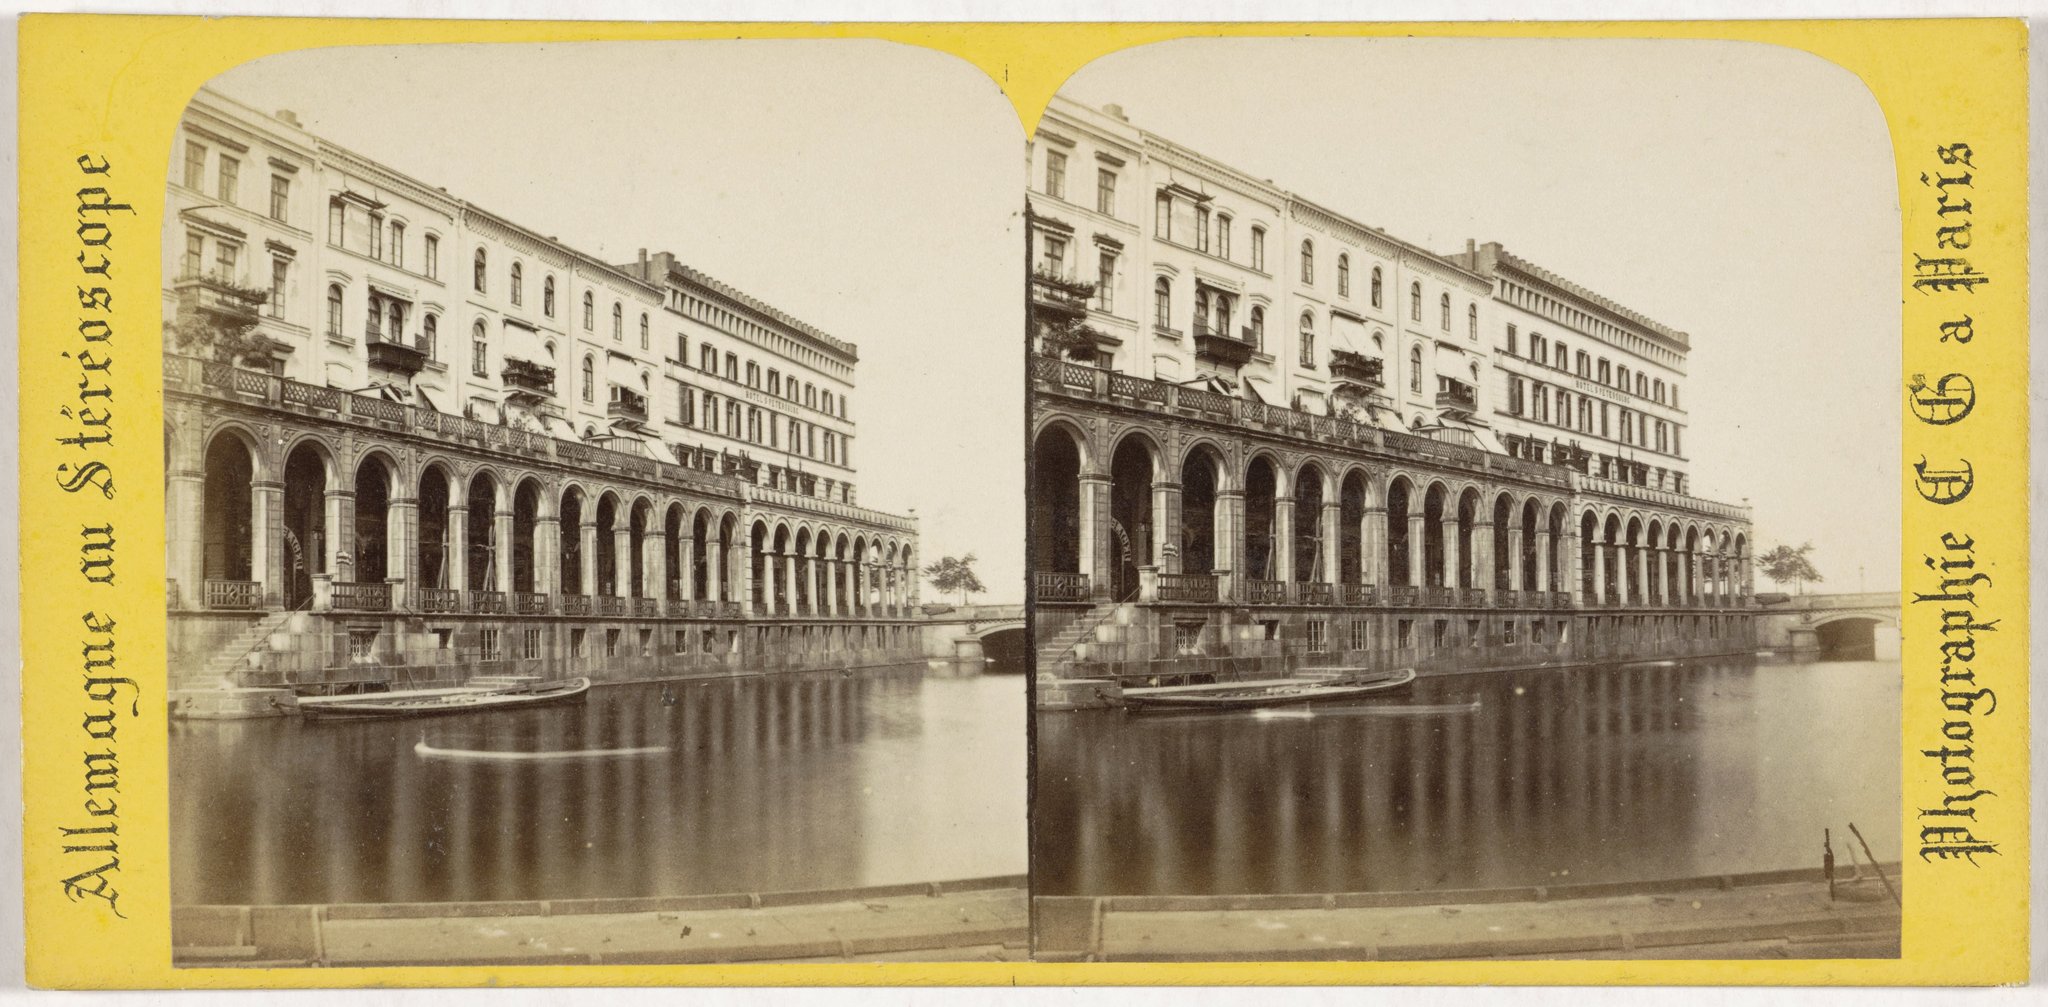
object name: stereograph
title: Alsterarkaden in Hamburg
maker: charles gaudin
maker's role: publisher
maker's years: 1825-1905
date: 1860-1870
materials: cardboard, paper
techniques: albumen print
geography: hamburg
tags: canals, waters (in city), arcade ~ architecture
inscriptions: number: ‘311.’